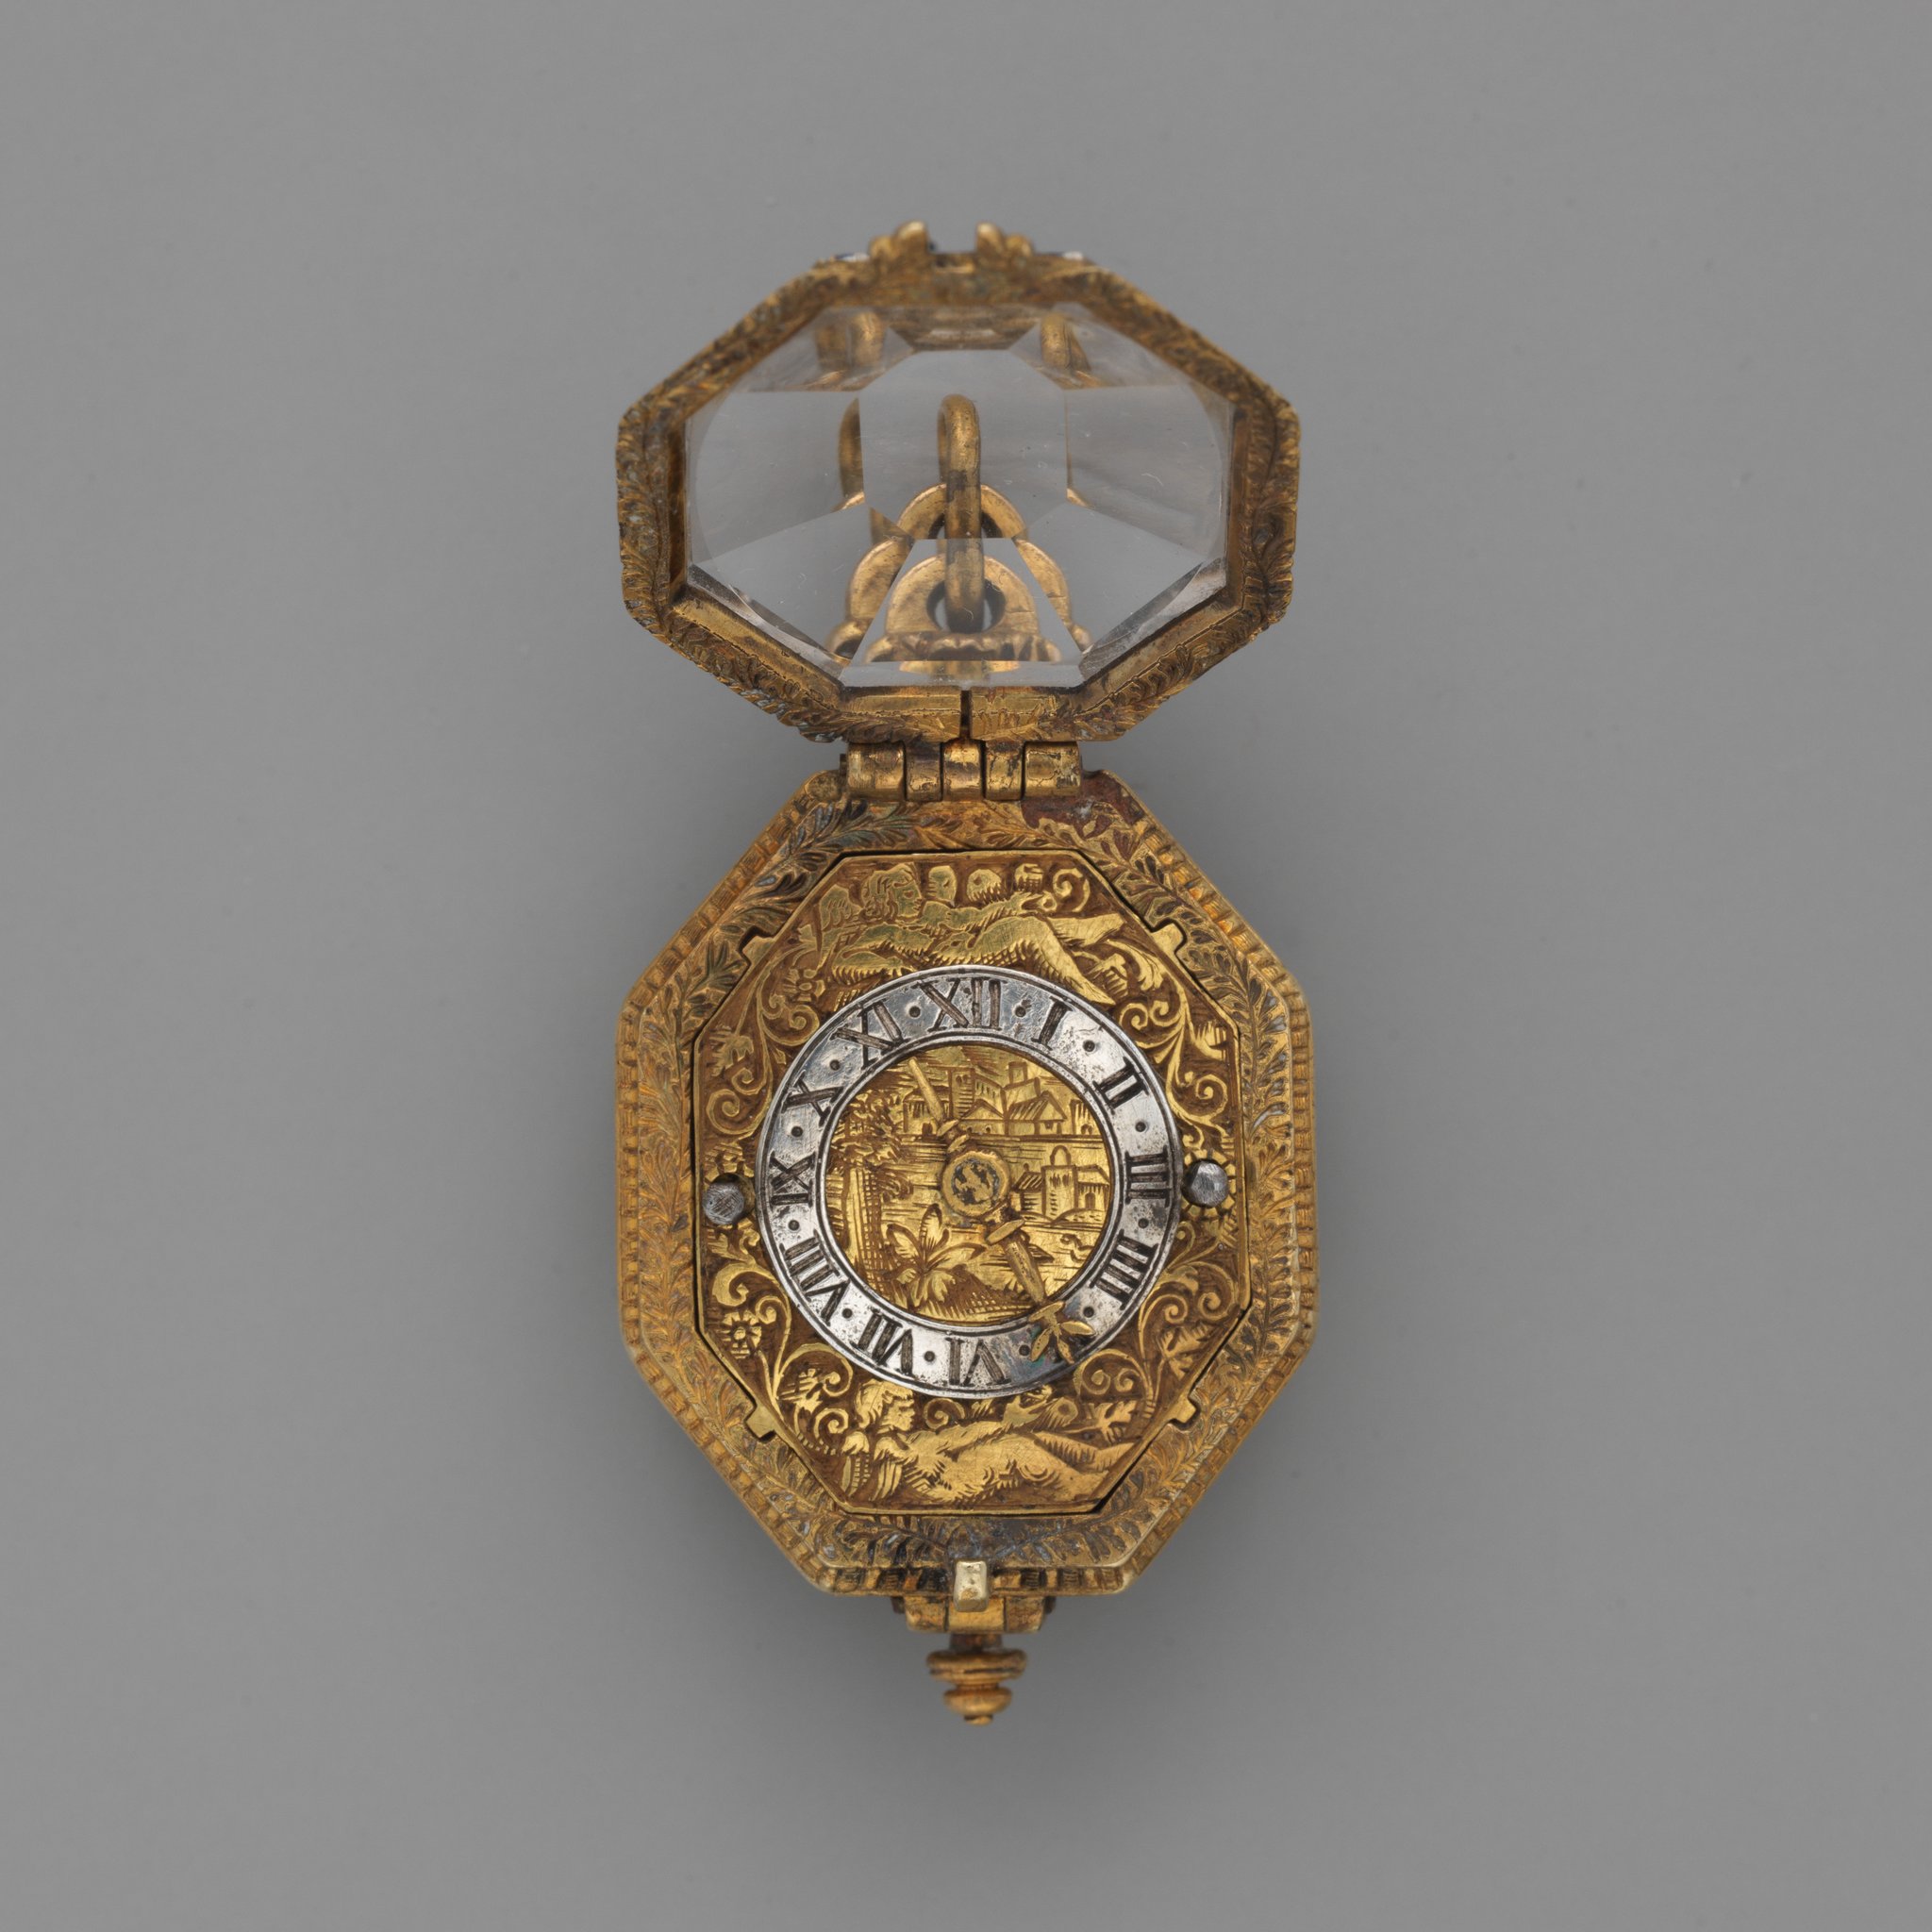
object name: watch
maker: richard ledertz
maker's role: maker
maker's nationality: german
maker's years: 1600-1630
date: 1620-1630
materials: brass, gilt, quartz, silver gilt, steel